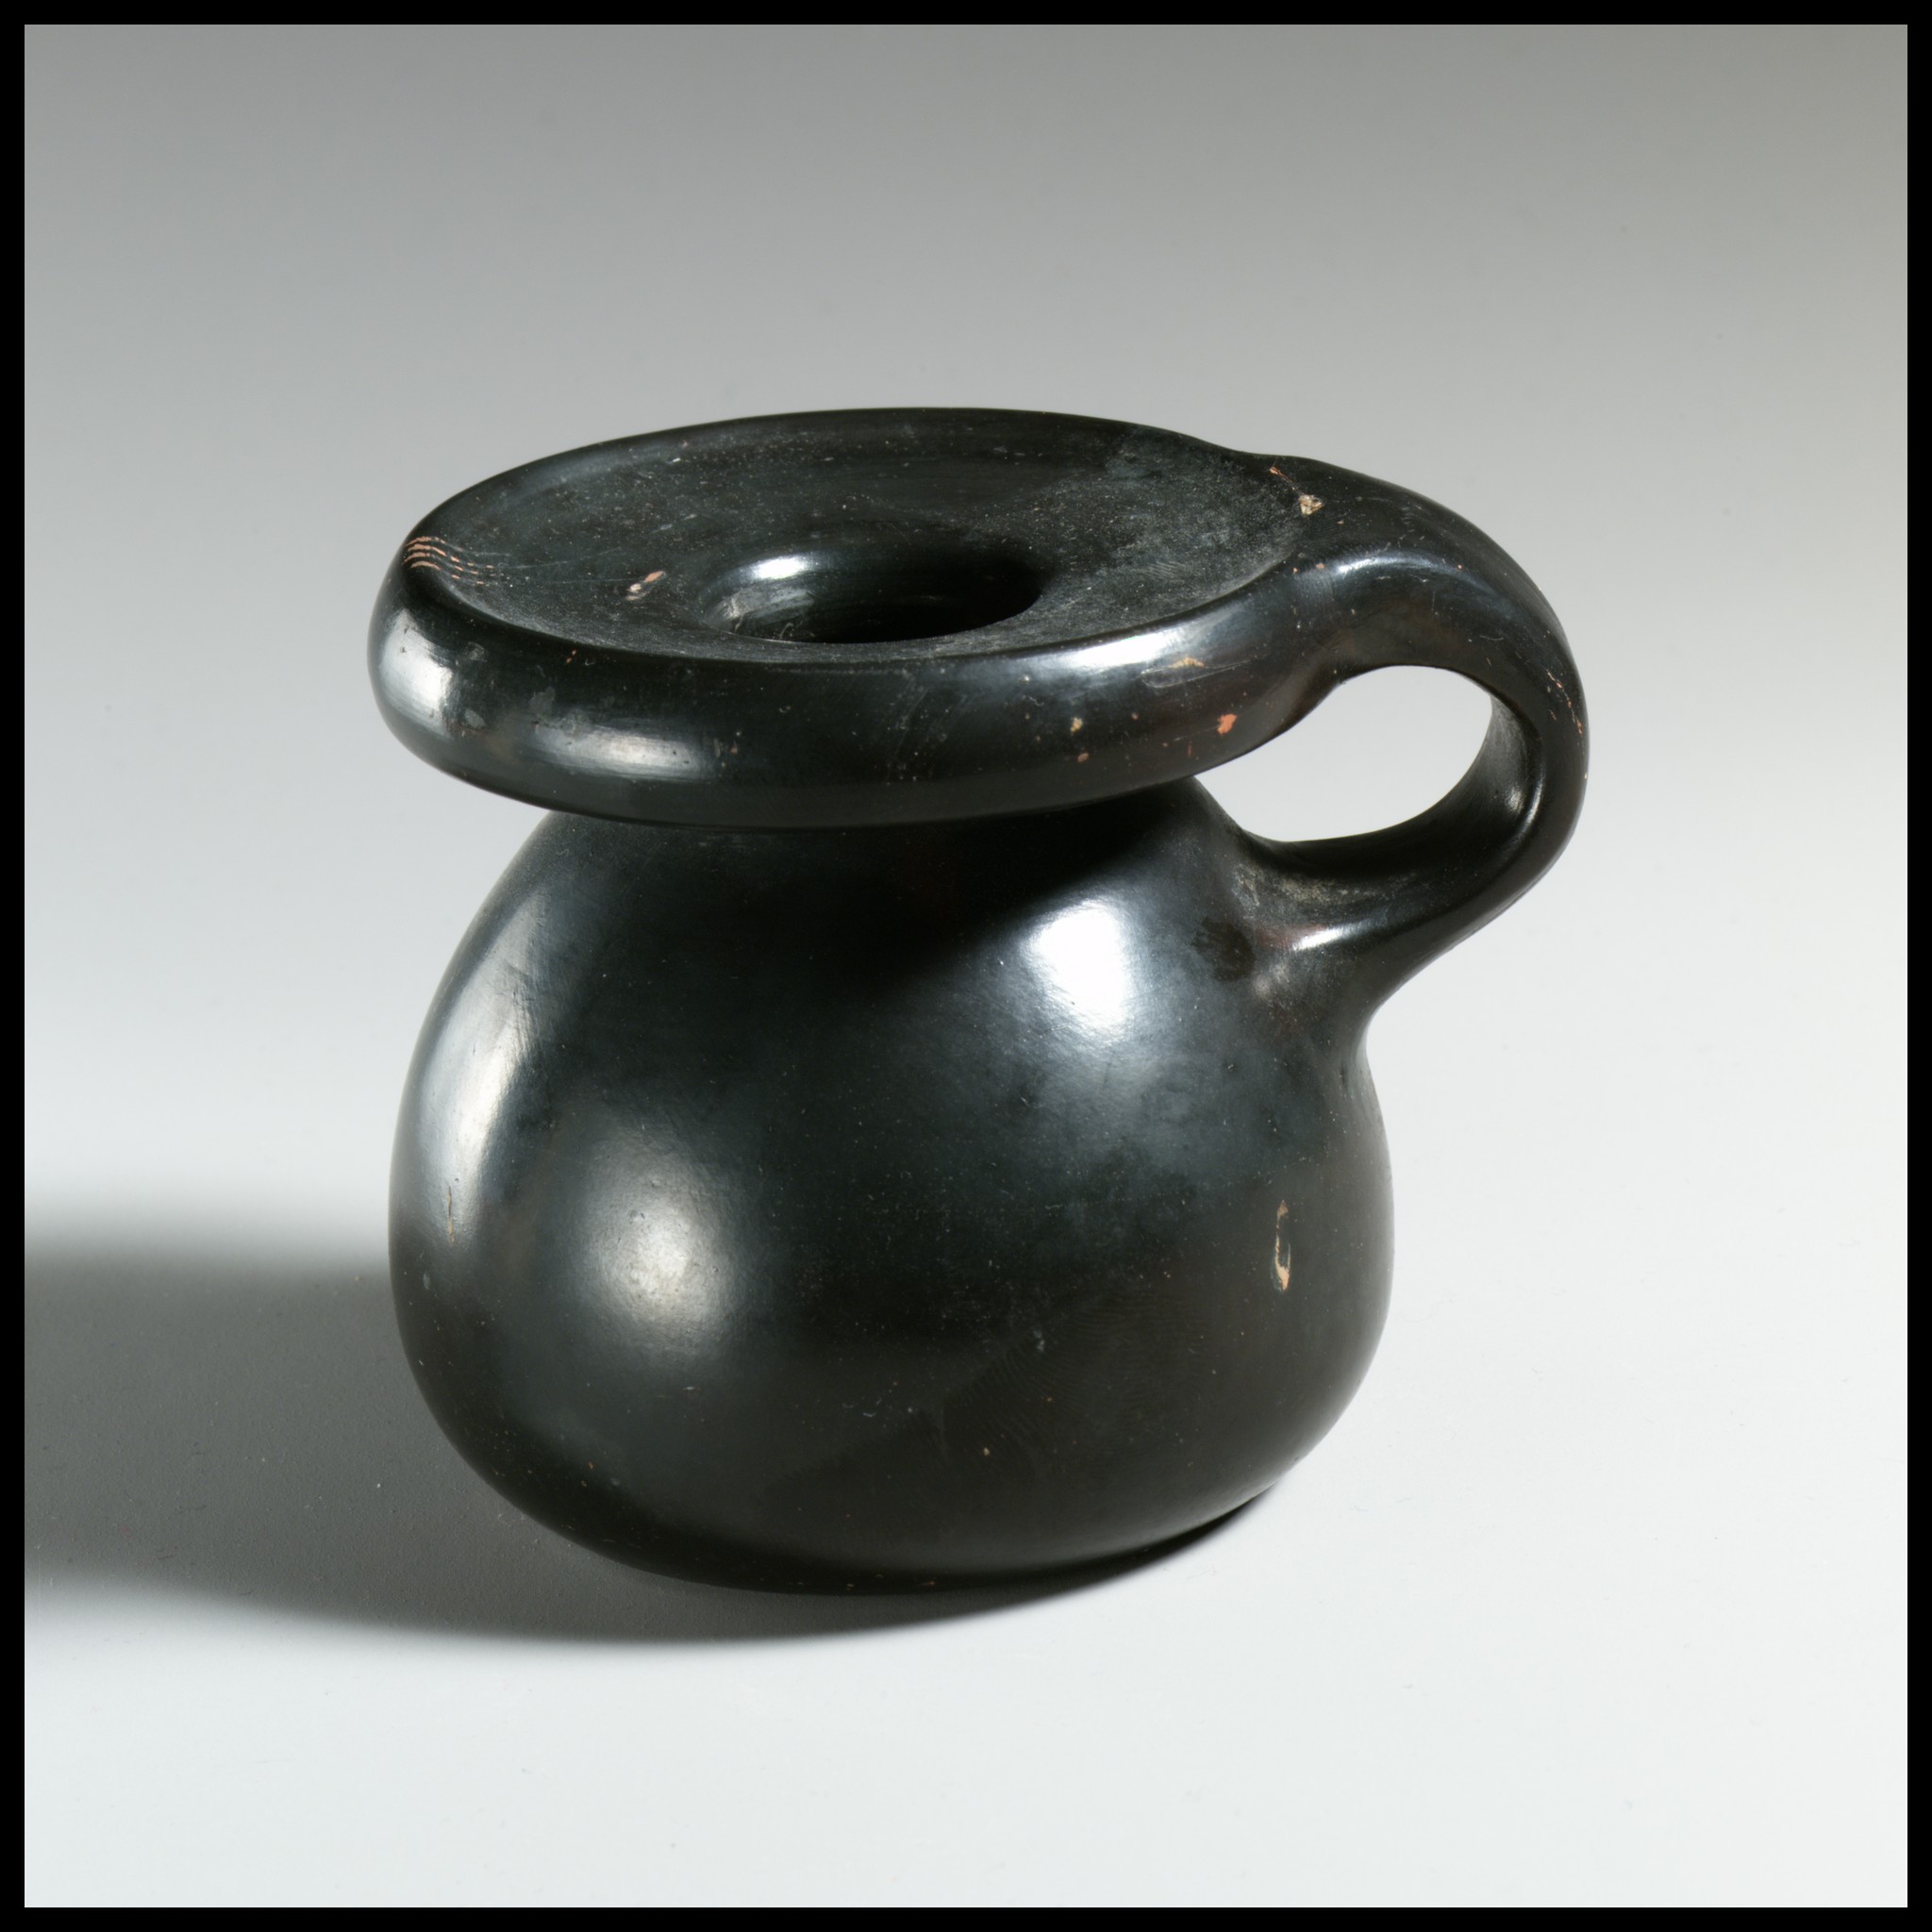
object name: mug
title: Terracotta perfume pot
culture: greek, south italian, apulian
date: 400-301 BCE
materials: terracotta